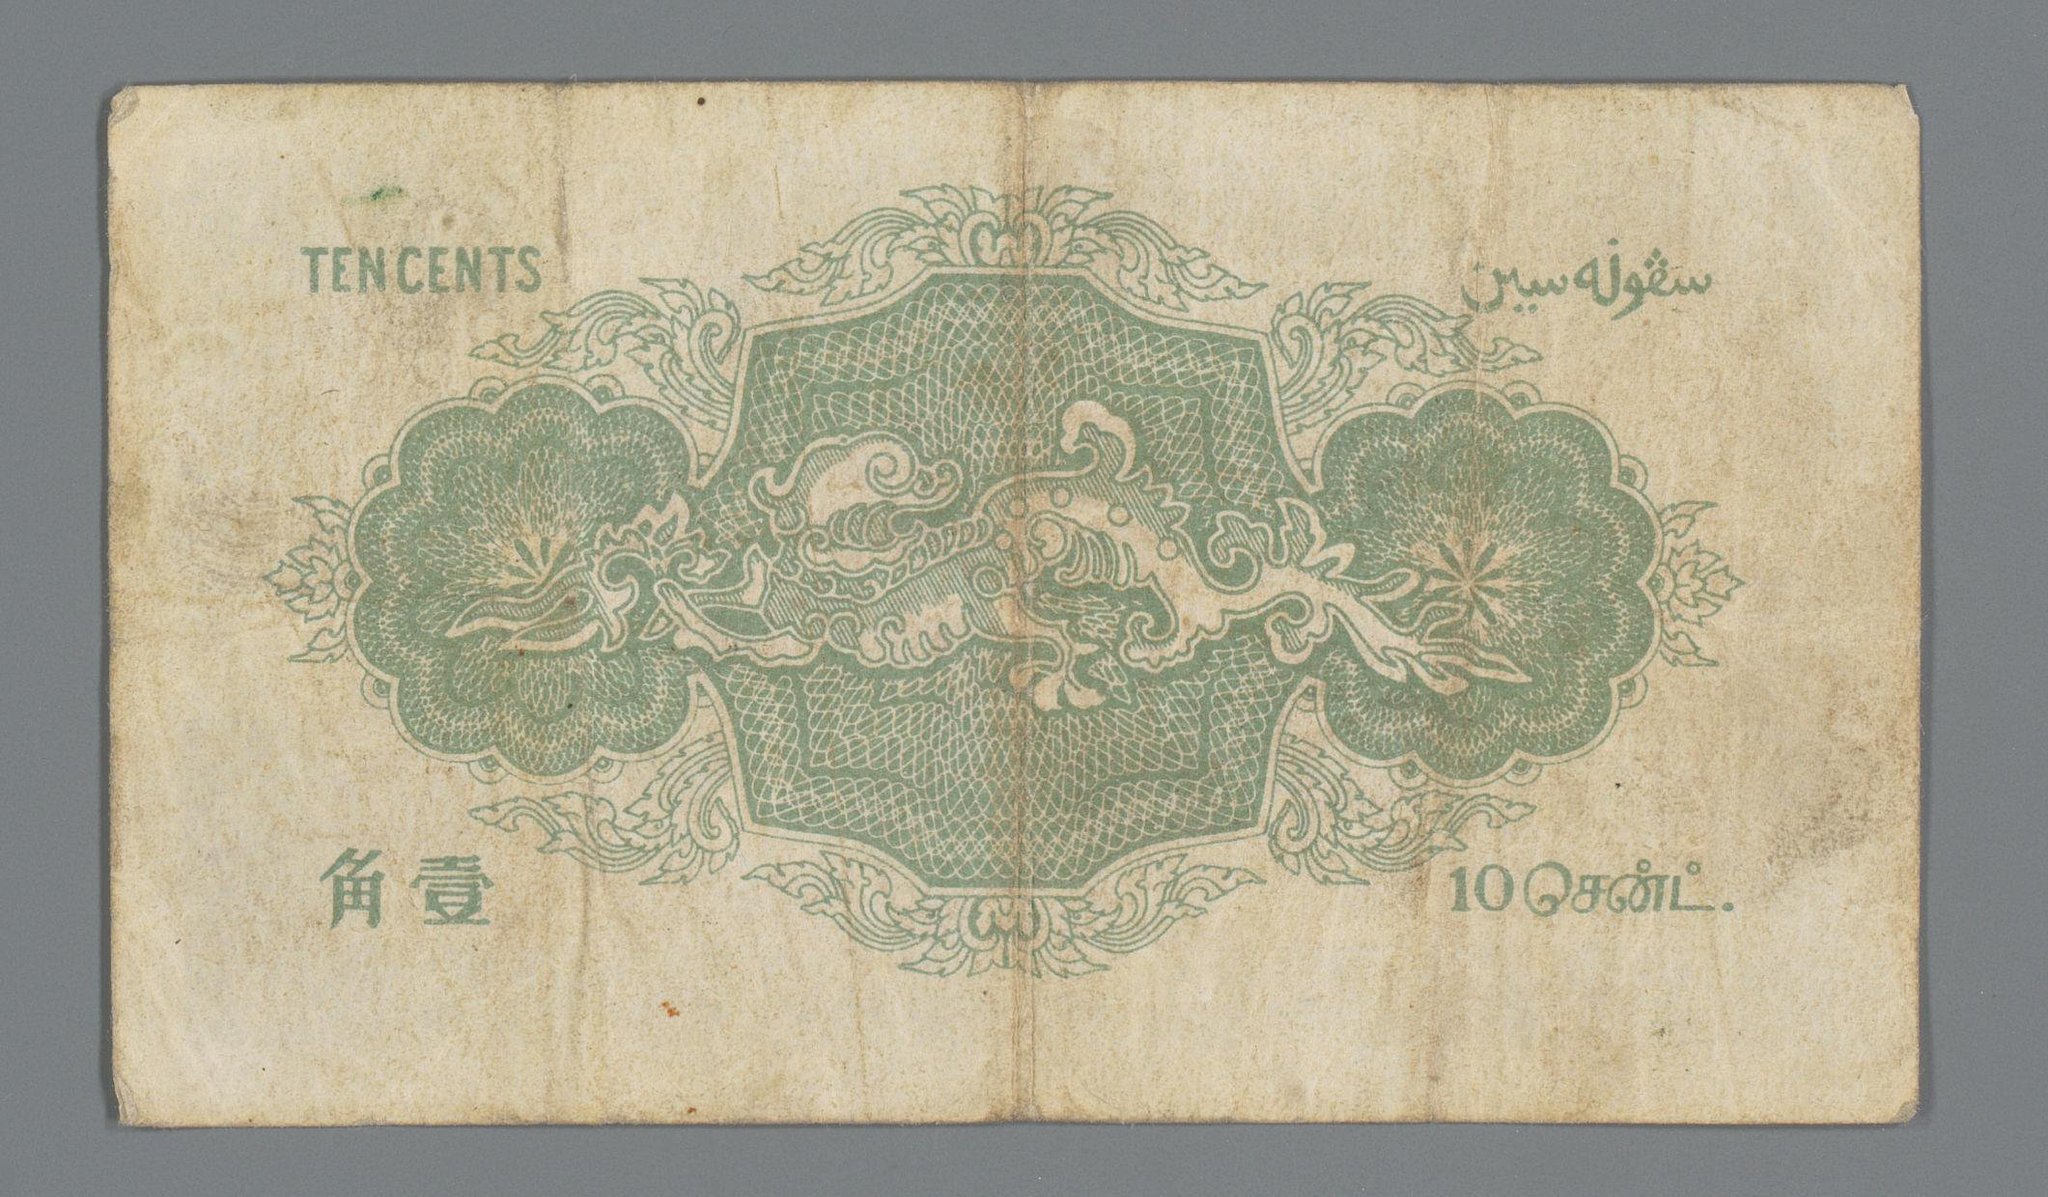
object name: biljet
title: Bankbiljet van de Straits Settlements ter waarde van 0,10 dollar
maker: Anonymous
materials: paper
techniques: lithograph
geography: straits settlements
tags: bank-note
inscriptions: inscription: ‘TEN CENTS’